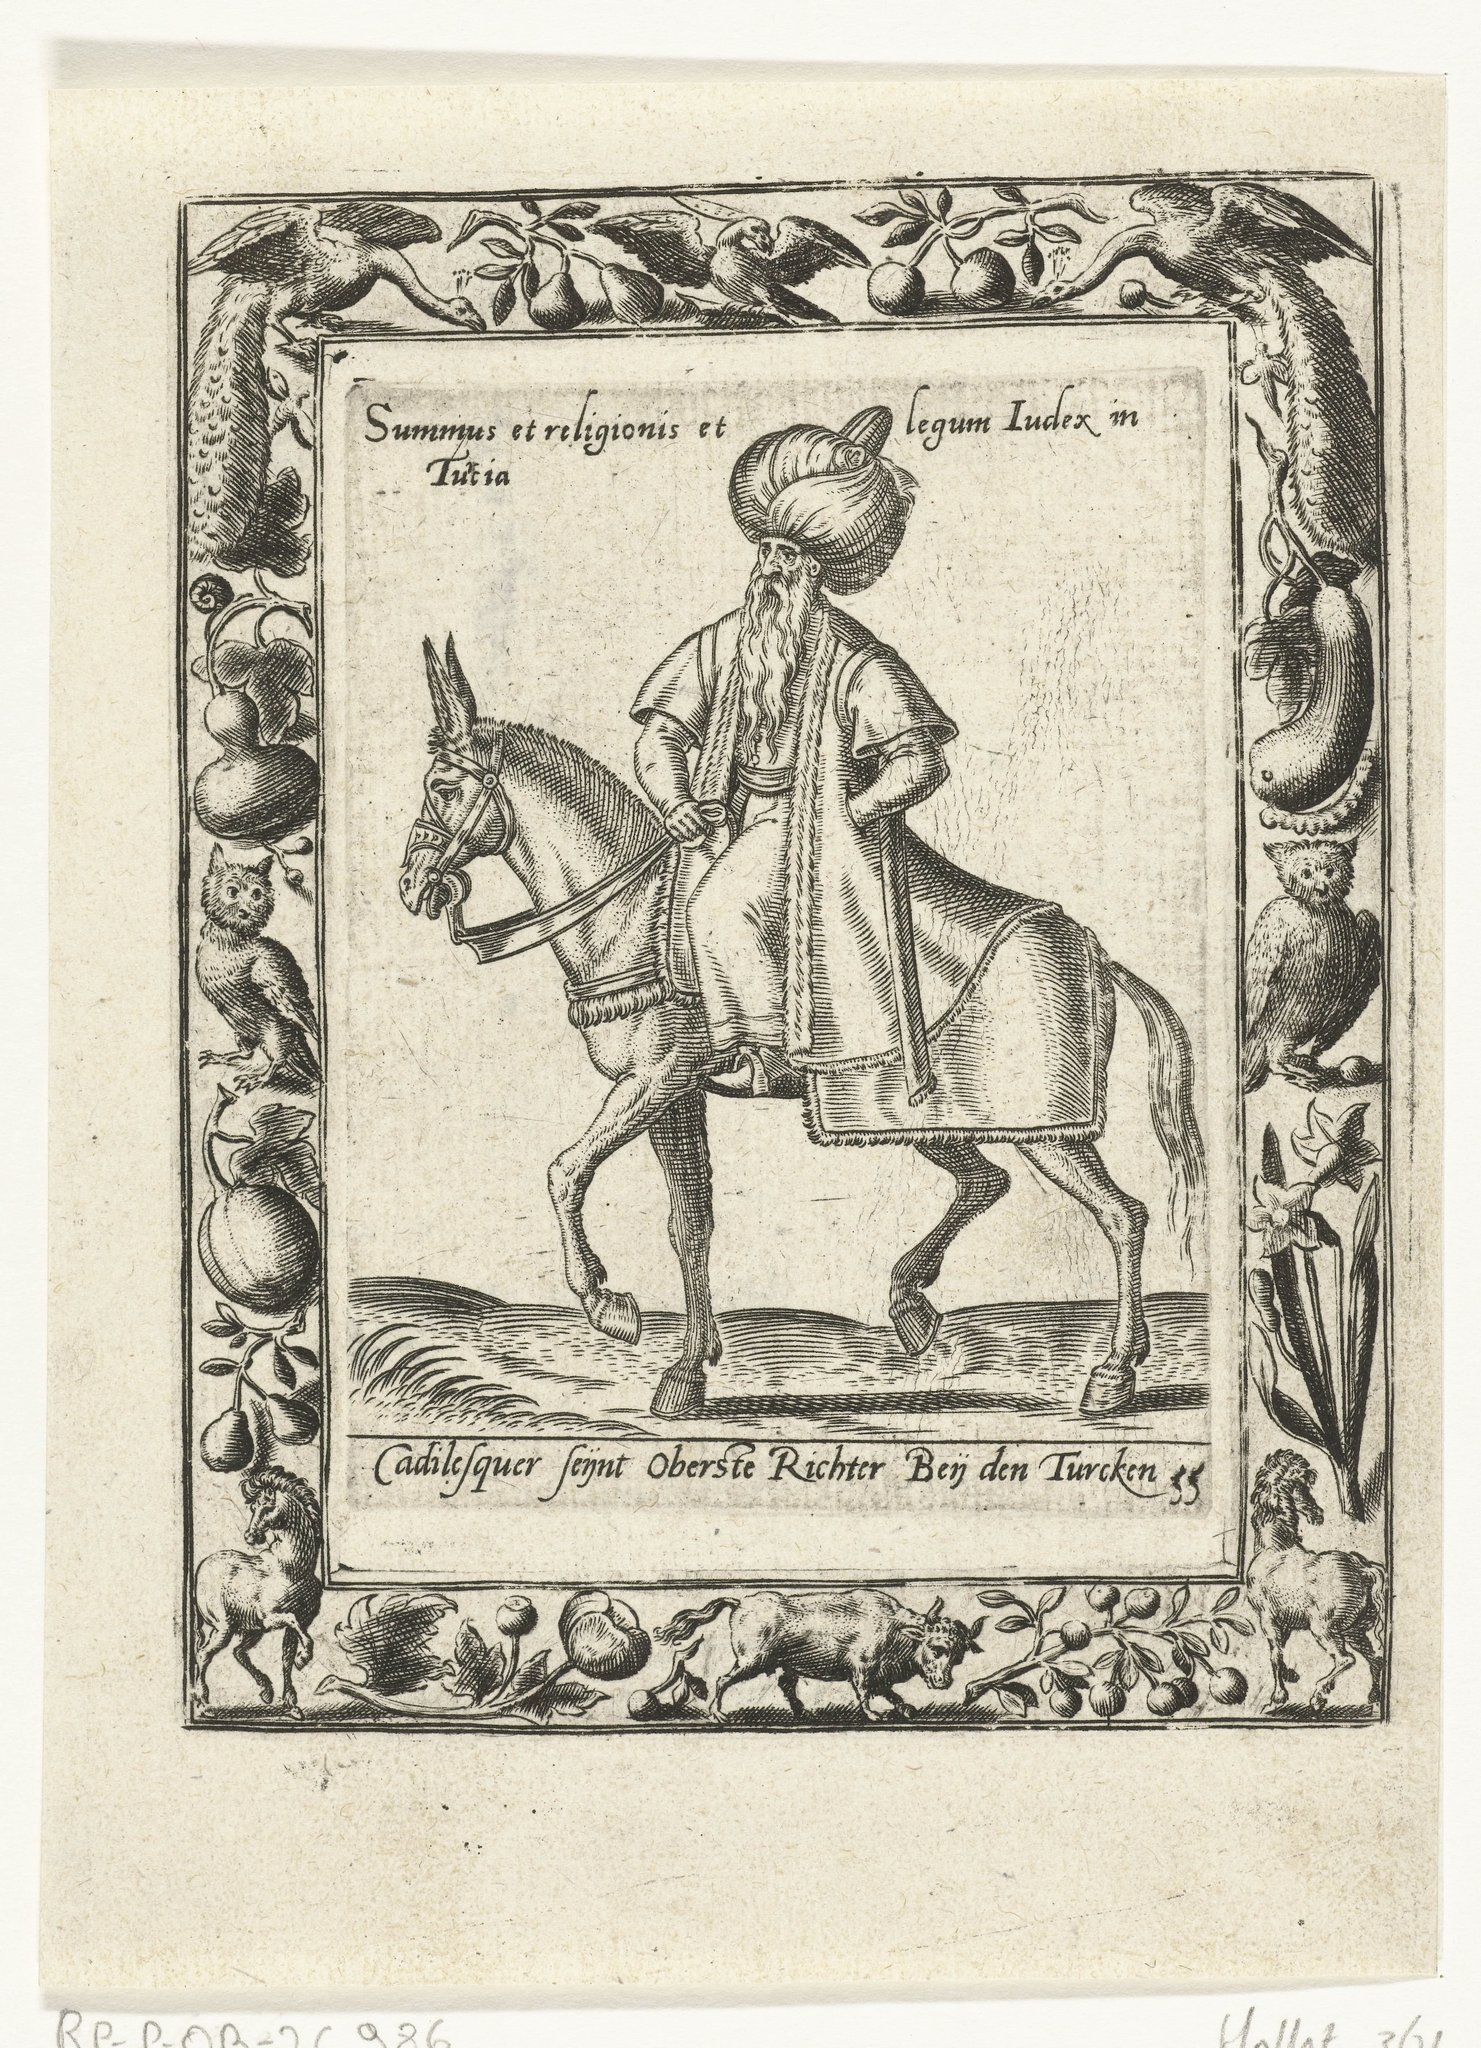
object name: costume print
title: Opperste rechter van Ottomaanse rijk te paard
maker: abraham de bruyn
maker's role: print maker, publisher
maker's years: 1540-1587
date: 1577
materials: paper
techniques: engraving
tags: asiatic races and peoples: turks, warfare; military affairs (+ cavalry, horsemen), law and jurisprudence (+ judge), folk costume, regional costume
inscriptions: collector's mark: Lugt 2228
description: Een cartouche met daarin de afbeelding van een paard en ruiter naar links. Het paard is in stap. De ruiter is gekleed als een Ottomaanse rechter. De prent heeft een Duits onderschrift en Latijns opschrift. Prent oorspronkelijk uit 'Equitum descripcio...', 1577.